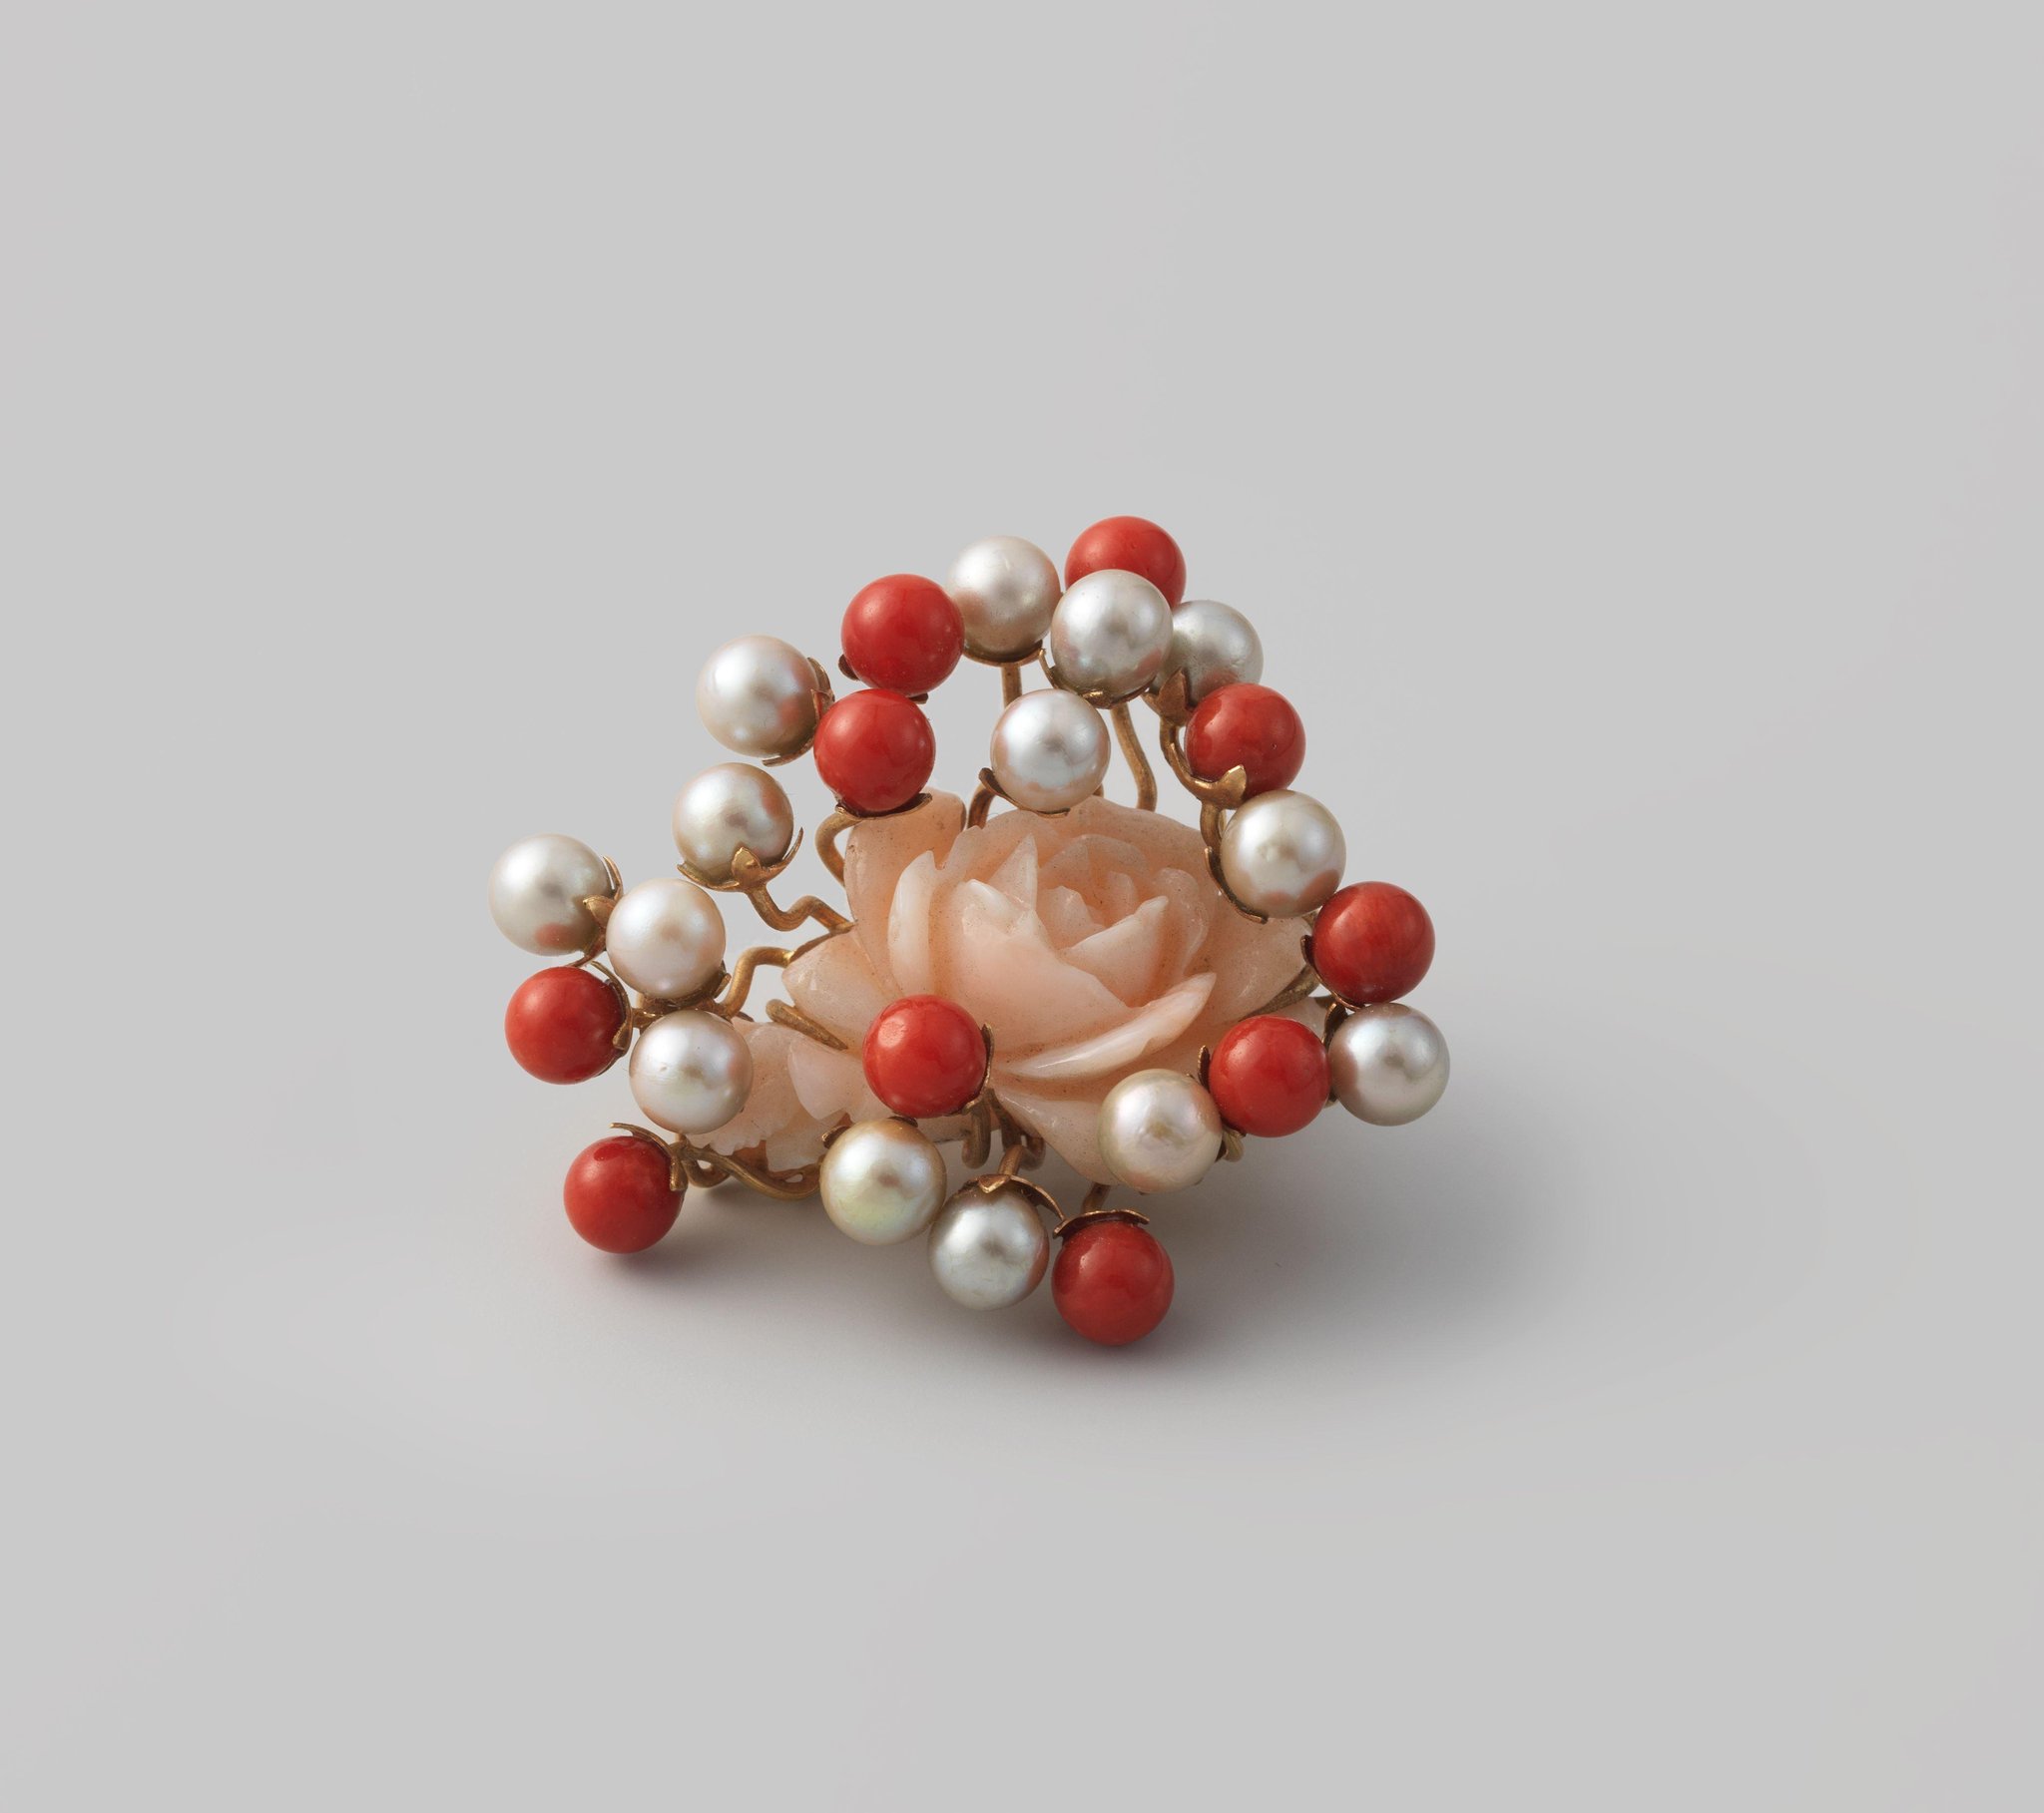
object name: brooch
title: Broche van goud, met bloedkoraal, parels en rozenkwarts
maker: Anonymous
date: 1960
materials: gold, coral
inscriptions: maker's mark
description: Broche van goud met een gesneden roos van lichte rozenkwarts, met tien ronde bloedkoralen en veertien cultivéparels, voorzien van een kogelsluiting.